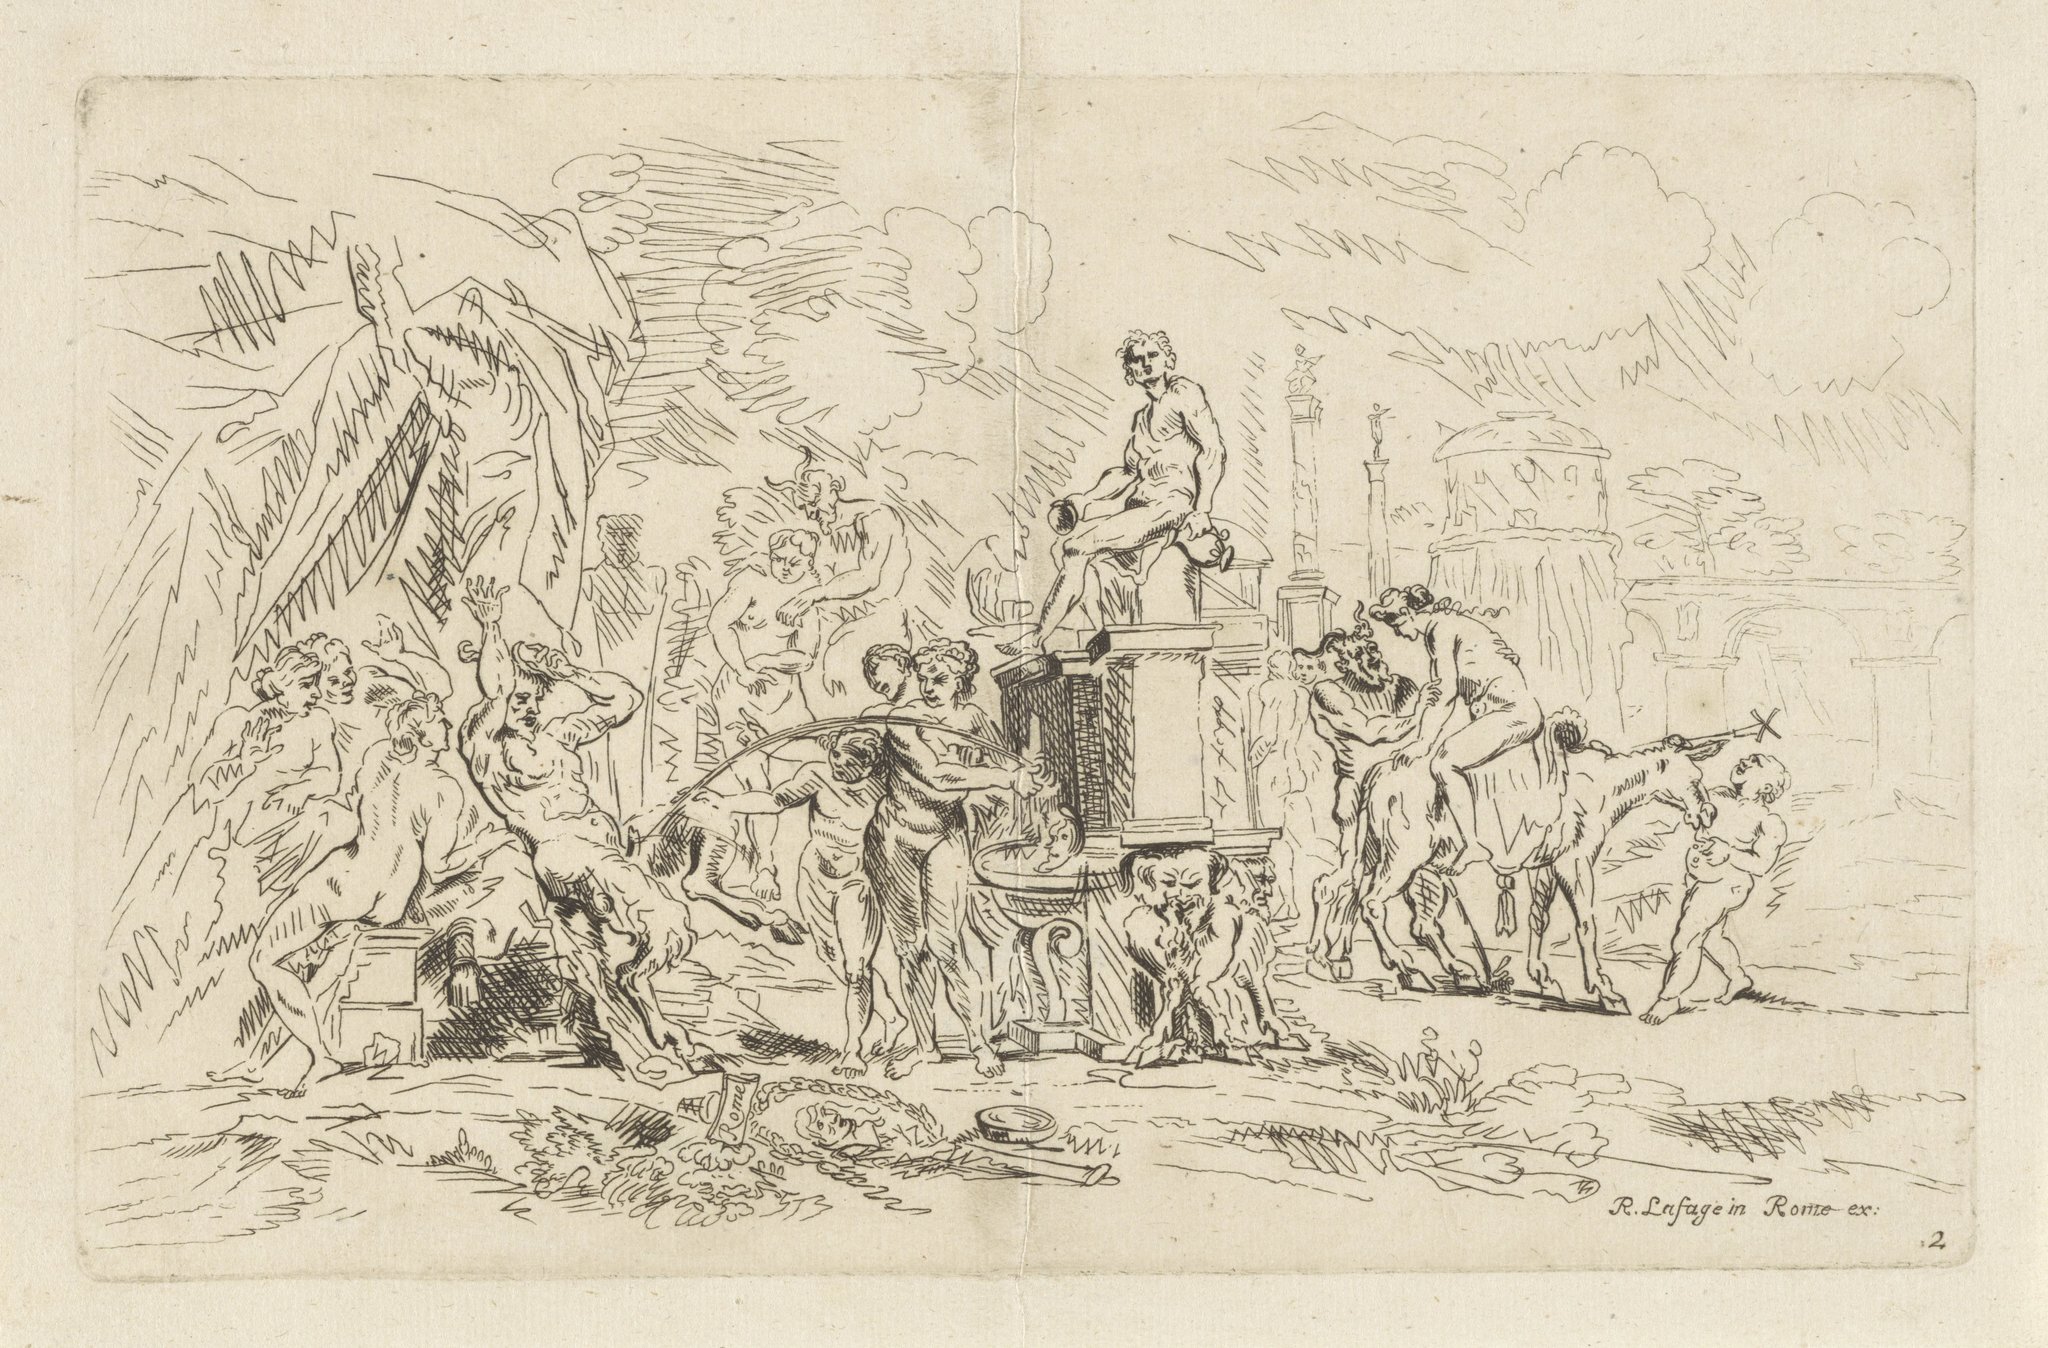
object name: print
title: Bacchanalen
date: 1668-1707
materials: paper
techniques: etching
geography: rome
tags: ass, donkey, bacchanal: bacchus with his wine-flushed train (thiasos), ornamental fountain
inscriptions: collector's mark: Lugt 2228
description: In het midden een beeld van Bacchus op een fontein. Links enkele saters en nimfen. Rechts een sater die een nimf achterstevoren op een ezel heeft gezet.